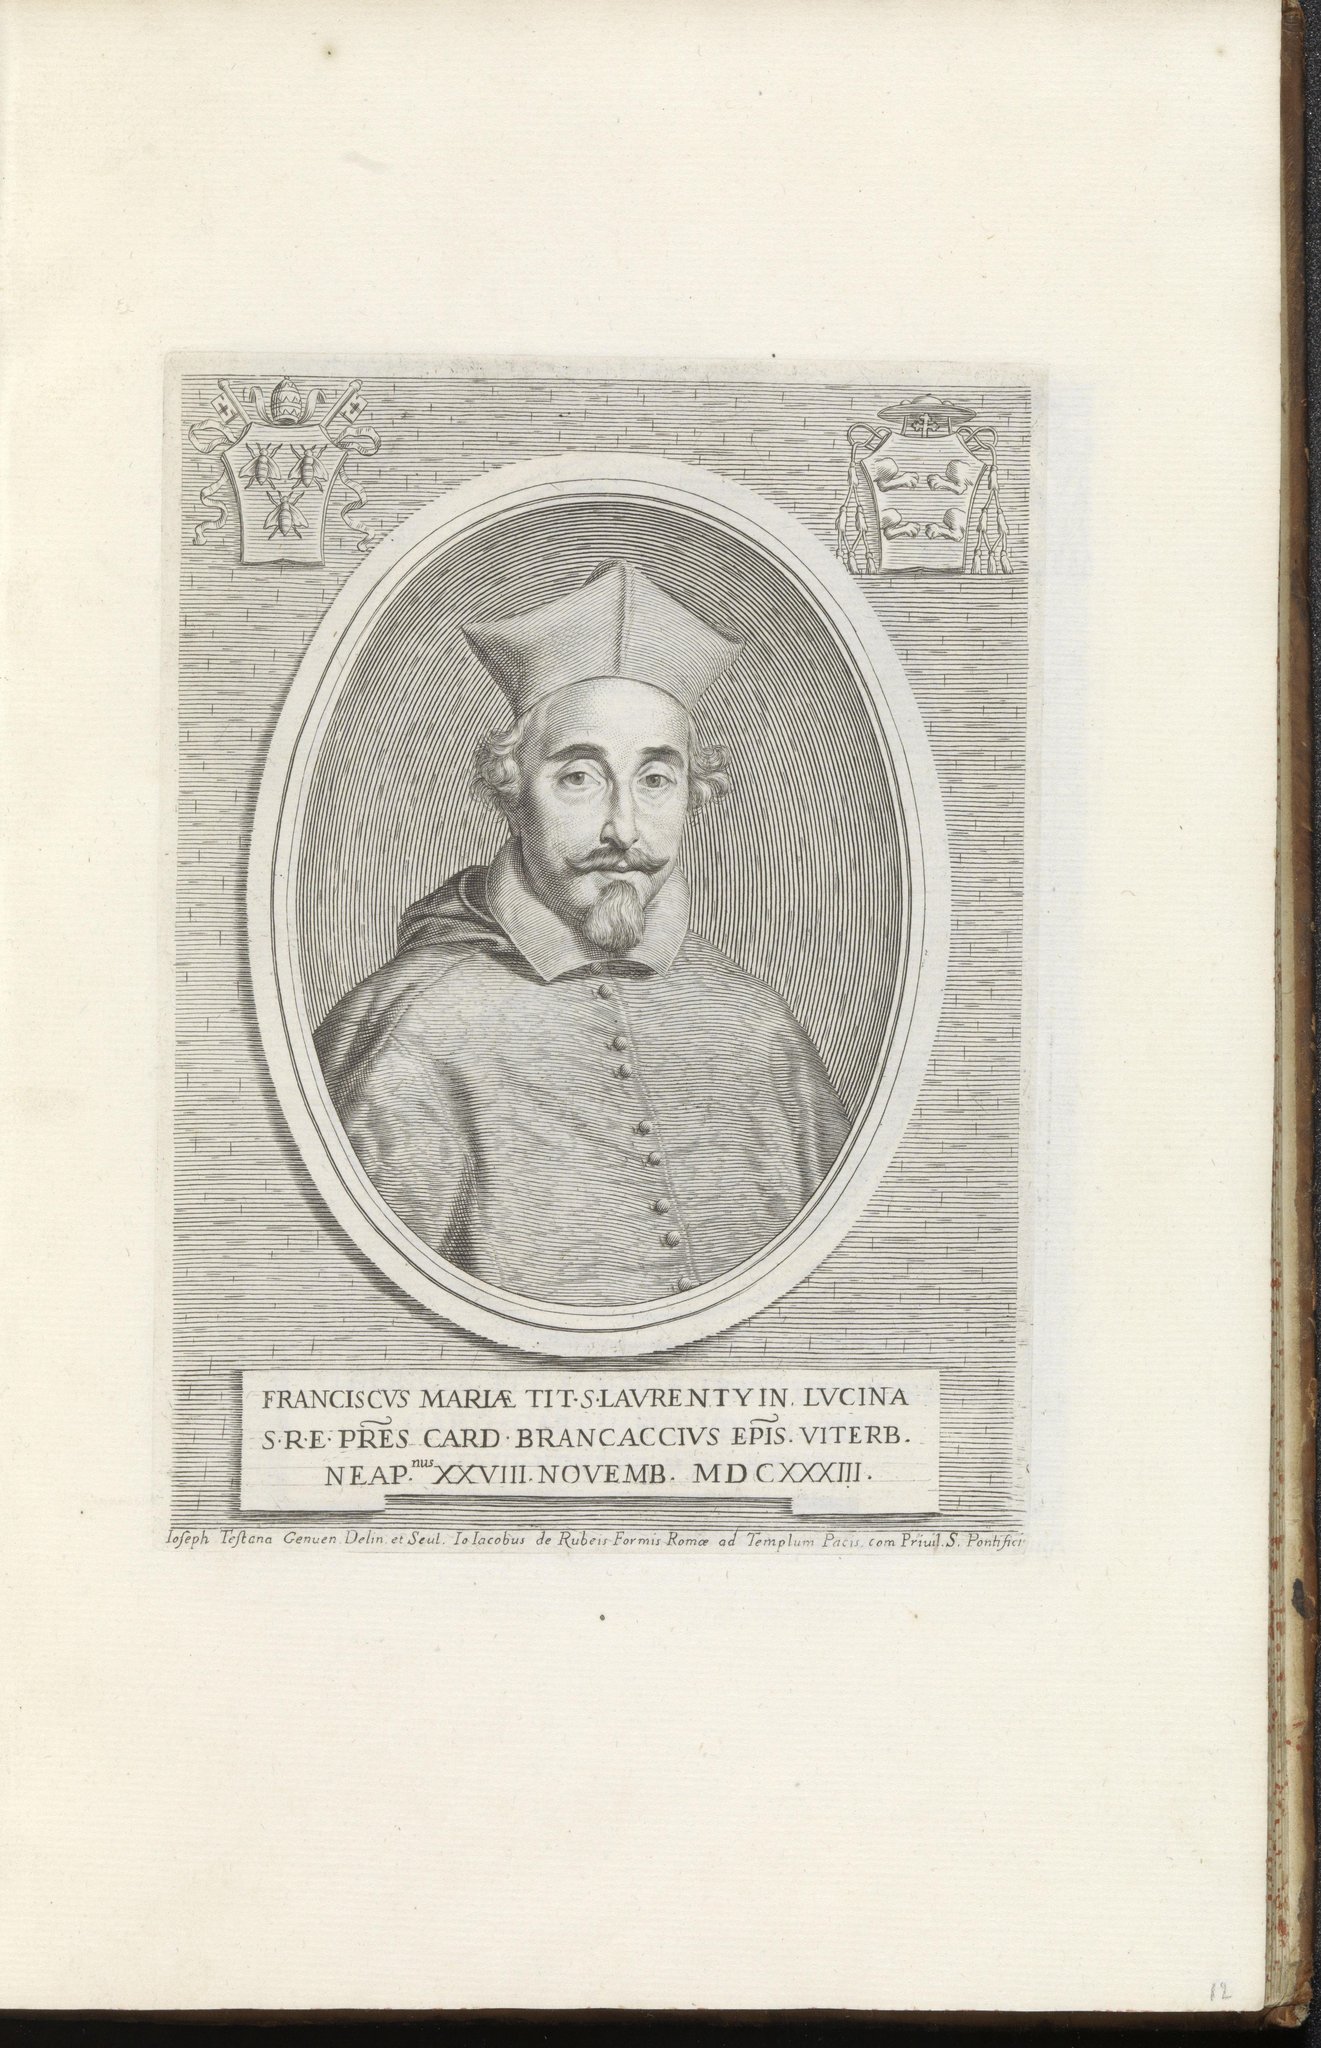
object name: album leaf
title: Portret van kardinaal Francesco Maria Brancaccio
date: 1658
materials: paper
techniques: engraving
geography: rome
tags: naples, cardinal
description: Portret van kardinaal Francesco Maria Brancaccio. Linksboven het wapen van paus Urbanus VIII en rechtsboven het wapen van kardinaal Brancaccio. Onderaan een onderschrift in het Latijn. De prent maakt deel uit van een album.